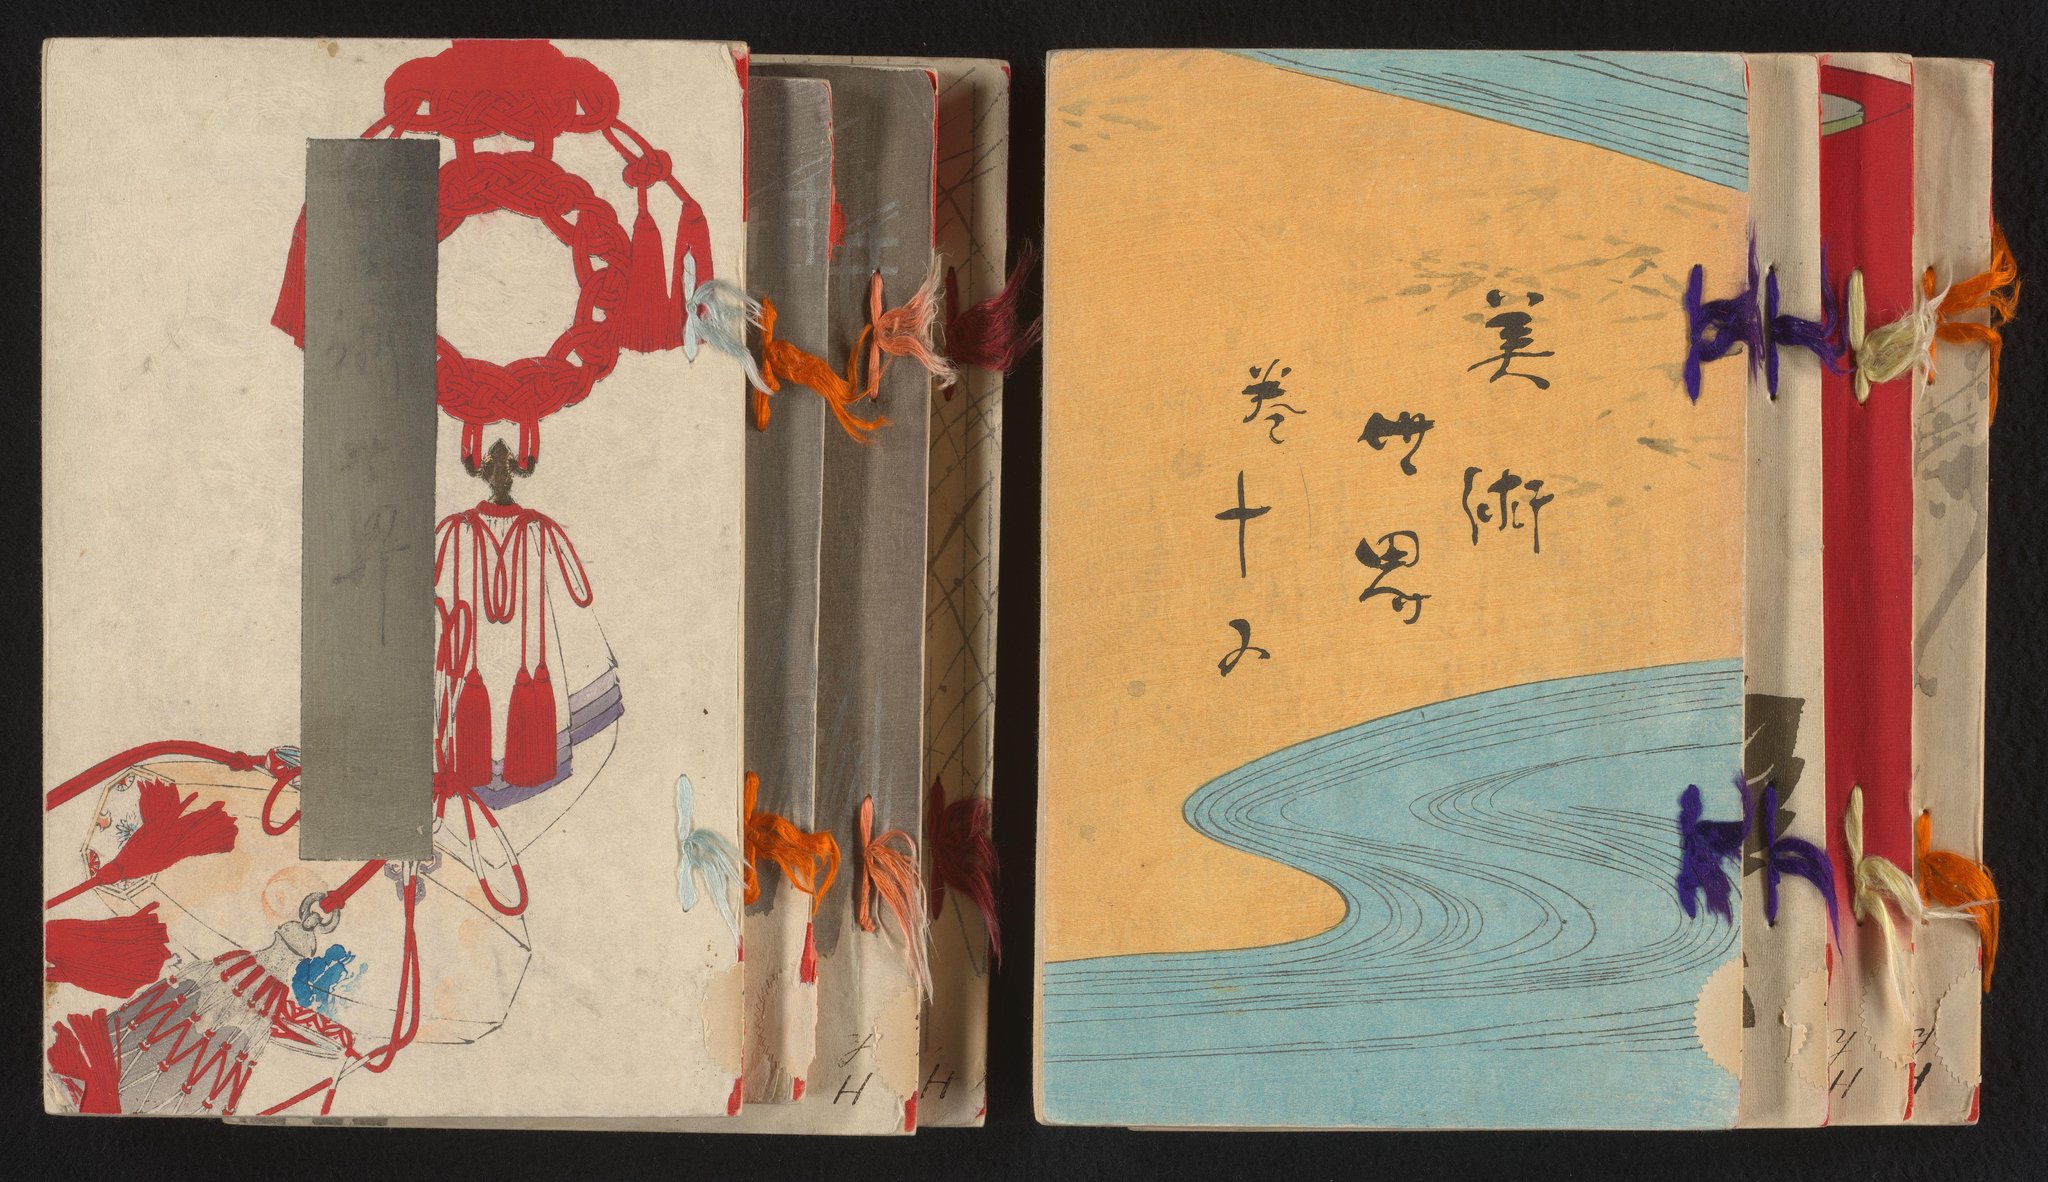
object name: book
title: Bijutsu sekai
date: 1890-1893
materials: paper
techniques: woodcut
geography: tokyo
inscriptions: collector's mark: ‘Rijksschool voor kunstnijverheid’ Lugt 3937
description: Serie boeken waar contemporaine kunstenaars bijdragen voor leverden, geïnspireerd op bekende prenten en schilderingen. Maandelijks verschenen er twee boekjes.